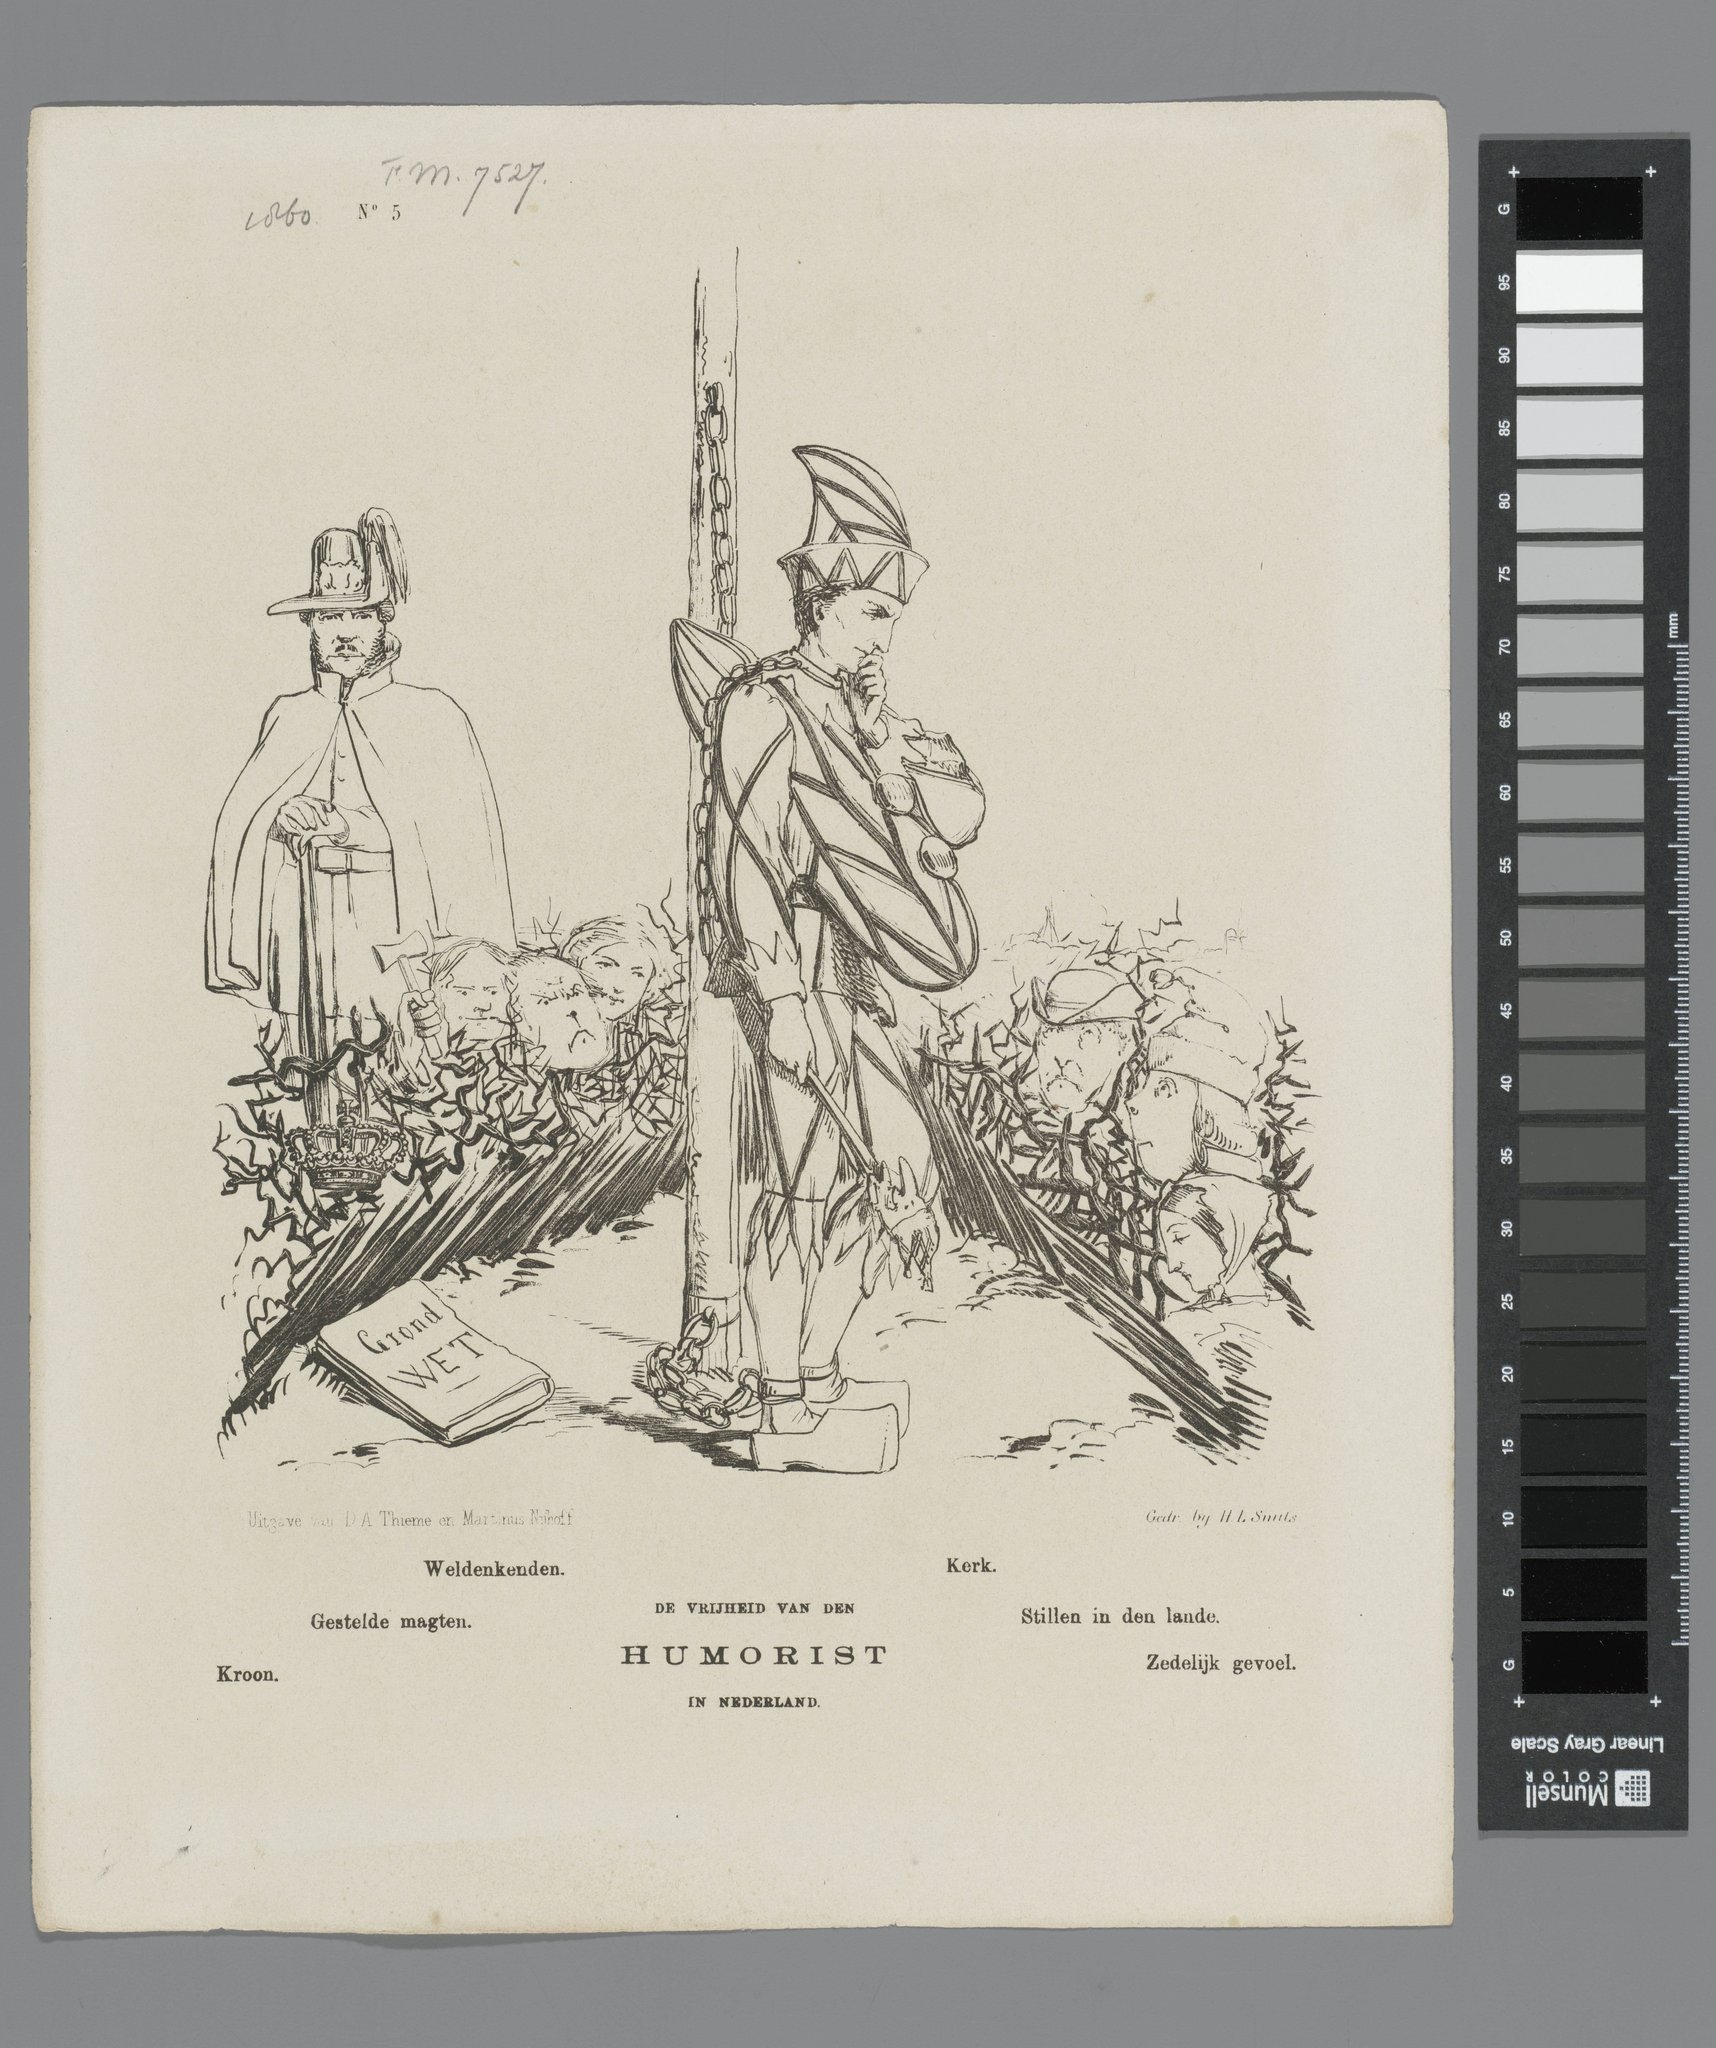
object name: cartoon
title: De vrijheid van de Humorist in Nederland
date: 1860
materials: paper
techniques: lithograph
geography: the hague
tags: violent death by burning at the stake; pyre, clown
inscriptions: collector's mark: Lugt 2228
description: Spotprent op de beperkte vrijheid van meningsuiting gegeven aan de humorist. Een clown (Jan Klaassen) geketend aan een staak op de brandstapel en scherp in de gaten gehouden door de autoriteiten. Plaat verschenen bij het weekblad De Nederlandsche Spectator, nr. 5, 4 februari 1860.